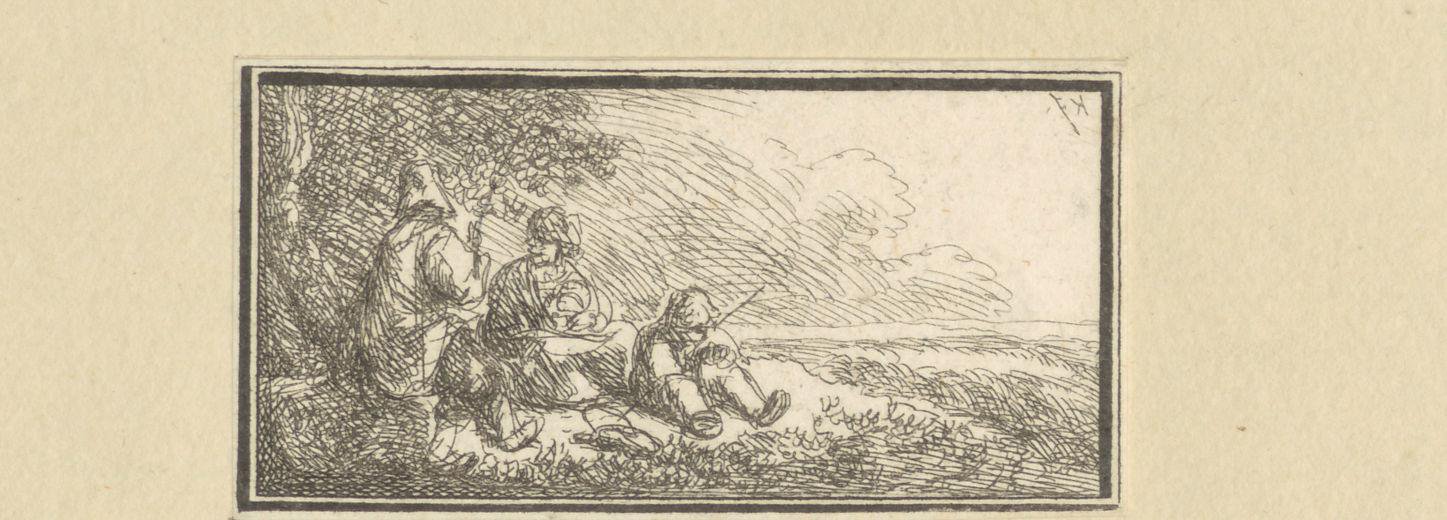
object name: print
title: Landschap met drie rustende reizigers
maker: johann christian klengel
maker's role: print maker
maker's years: 1751-1824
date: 1761-1824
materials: paper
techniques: etching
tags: meadow, pasture, (traveller) resting in the open air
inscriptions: collector's mark: Lugt 240